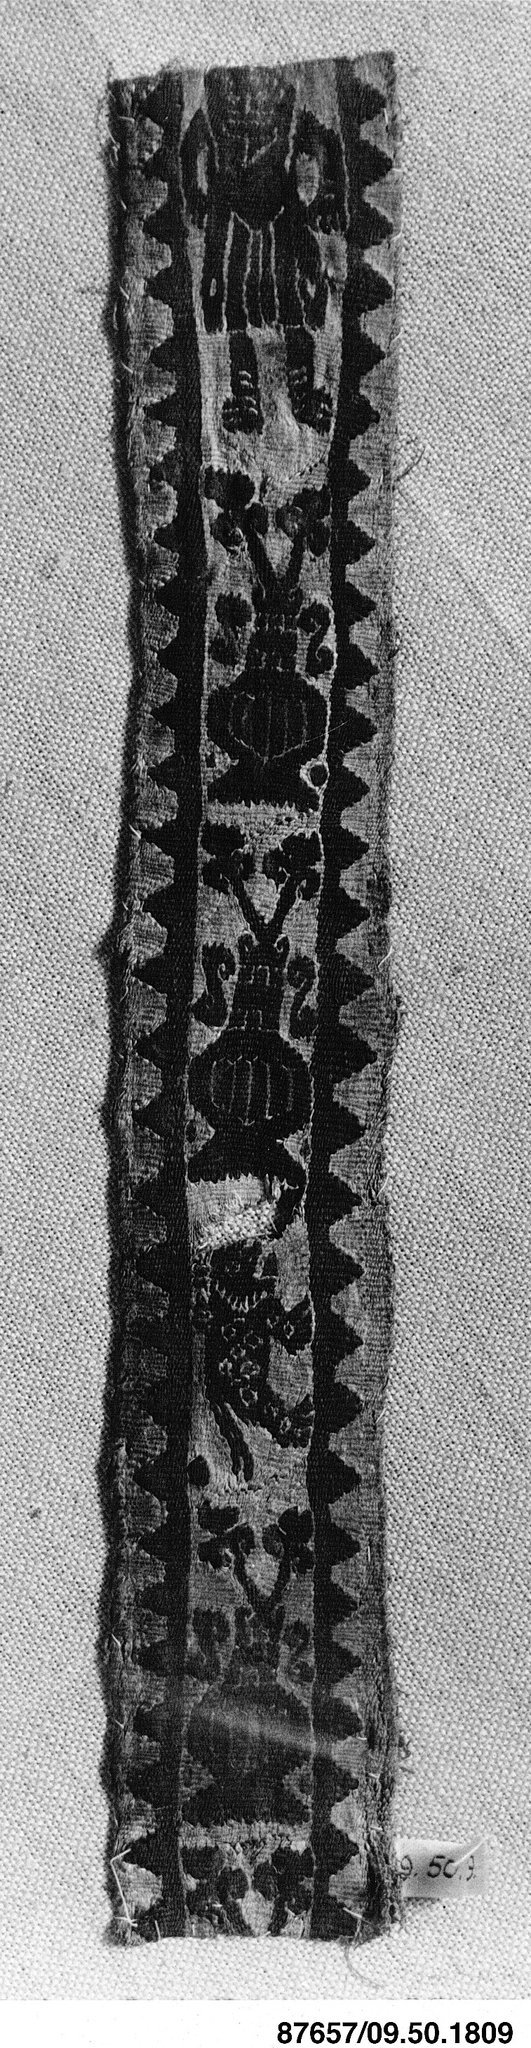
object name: band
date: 201-400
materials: linen, wool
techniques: weave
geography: egypt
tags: human figures,animals